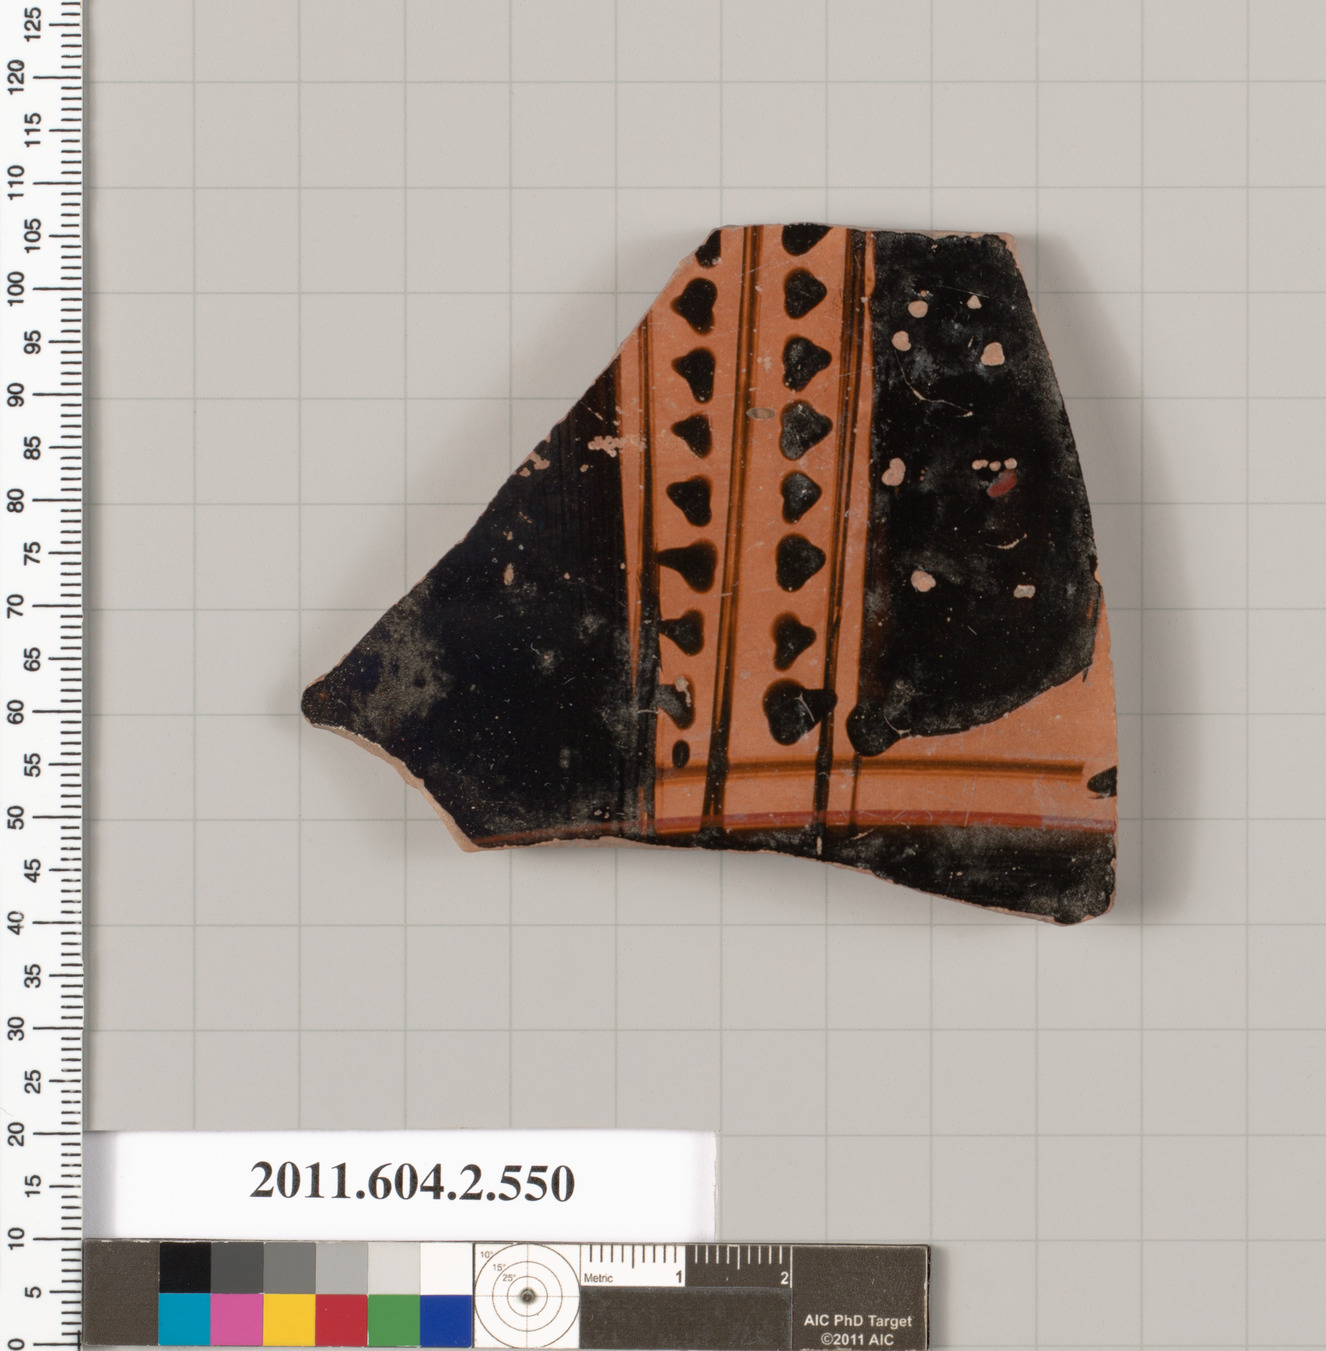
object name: column krater fragment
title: Terracotta fragment of a column-krater (bowl for mixing wine and water)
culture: greek, attic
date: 450-430 BCE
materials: terracotta